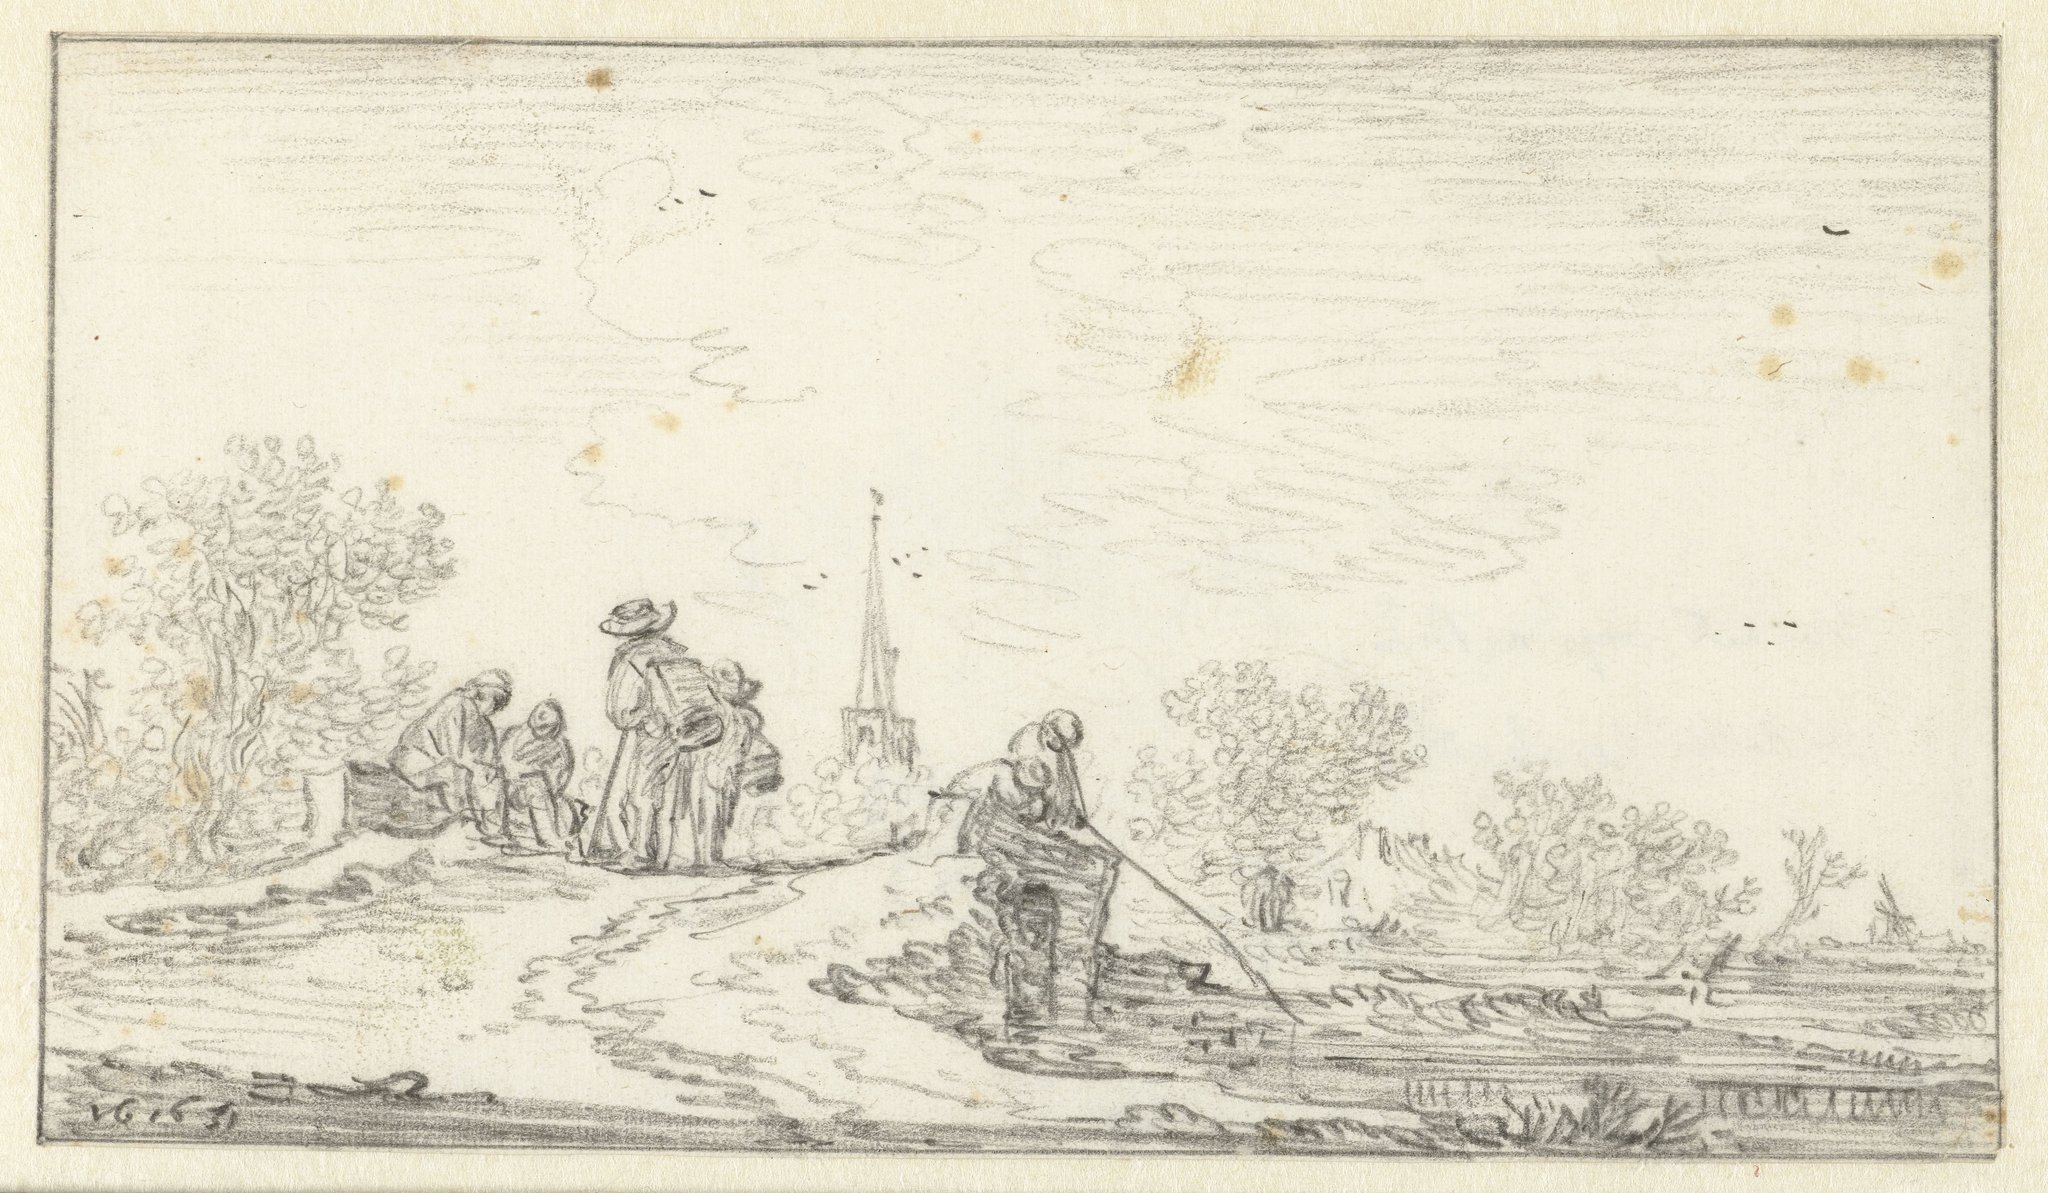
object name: drawing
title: Figuren op een stenen bruggetje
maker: jan van goyen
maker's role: draughtsman, painter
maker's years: 1596-1656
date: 1631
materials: chalk, paper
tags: landscape with bridge, viaduct or aqueduct, angling